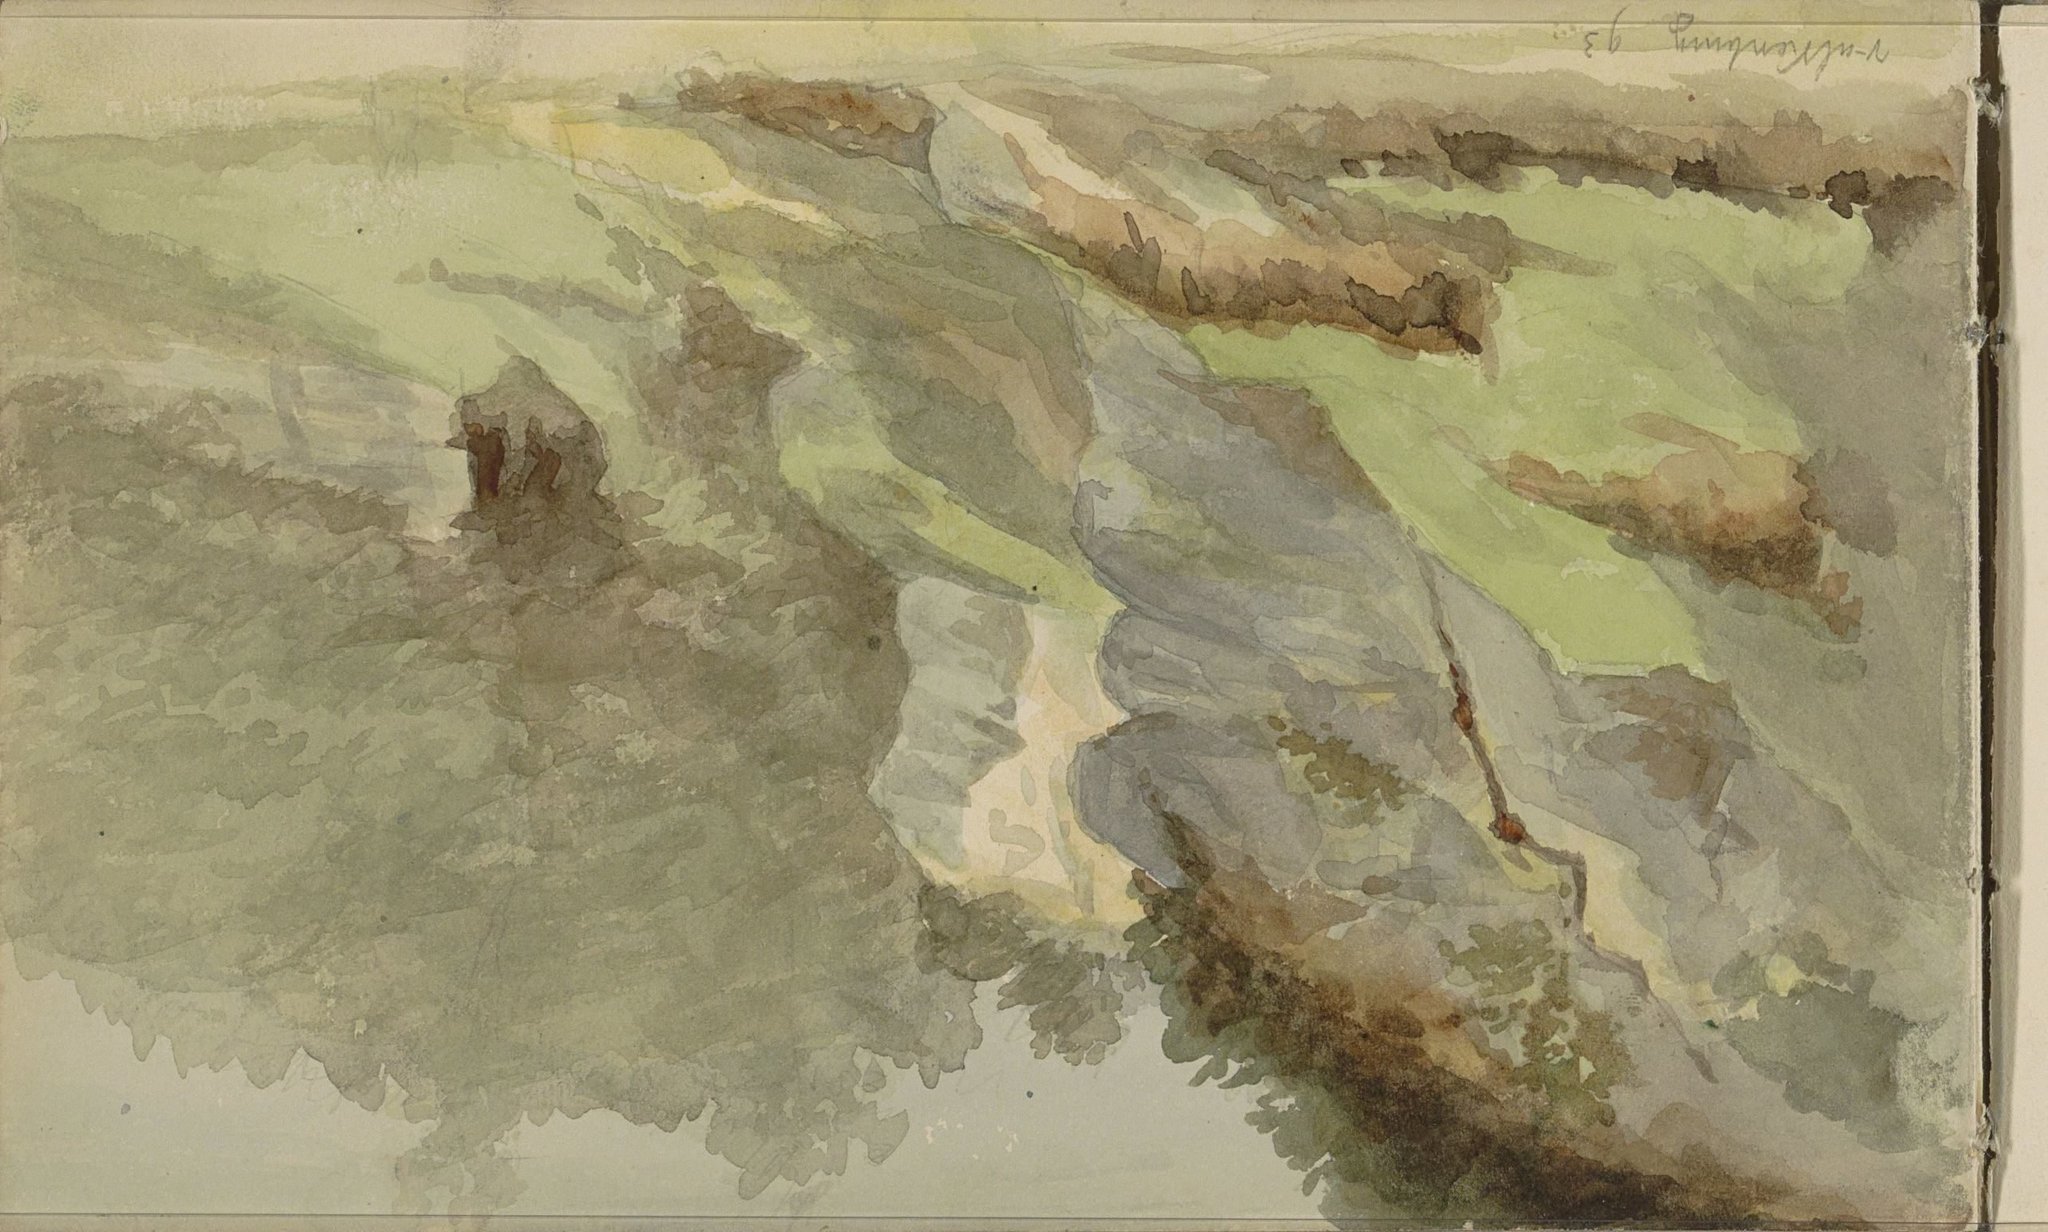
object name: sketchbook leaf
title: Mergelwand te Valkenburg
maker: anna catharina maria van eeghen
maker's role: draughtsman, print maker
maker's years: 1878-1924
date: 1893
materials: paper, pencil, watercolor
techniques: brush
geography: valkenburg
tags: rocks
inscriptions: date and inscription: ‘Valkenburg 93’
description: Blad 28 verso uit een schetsboek met 33 bladen.